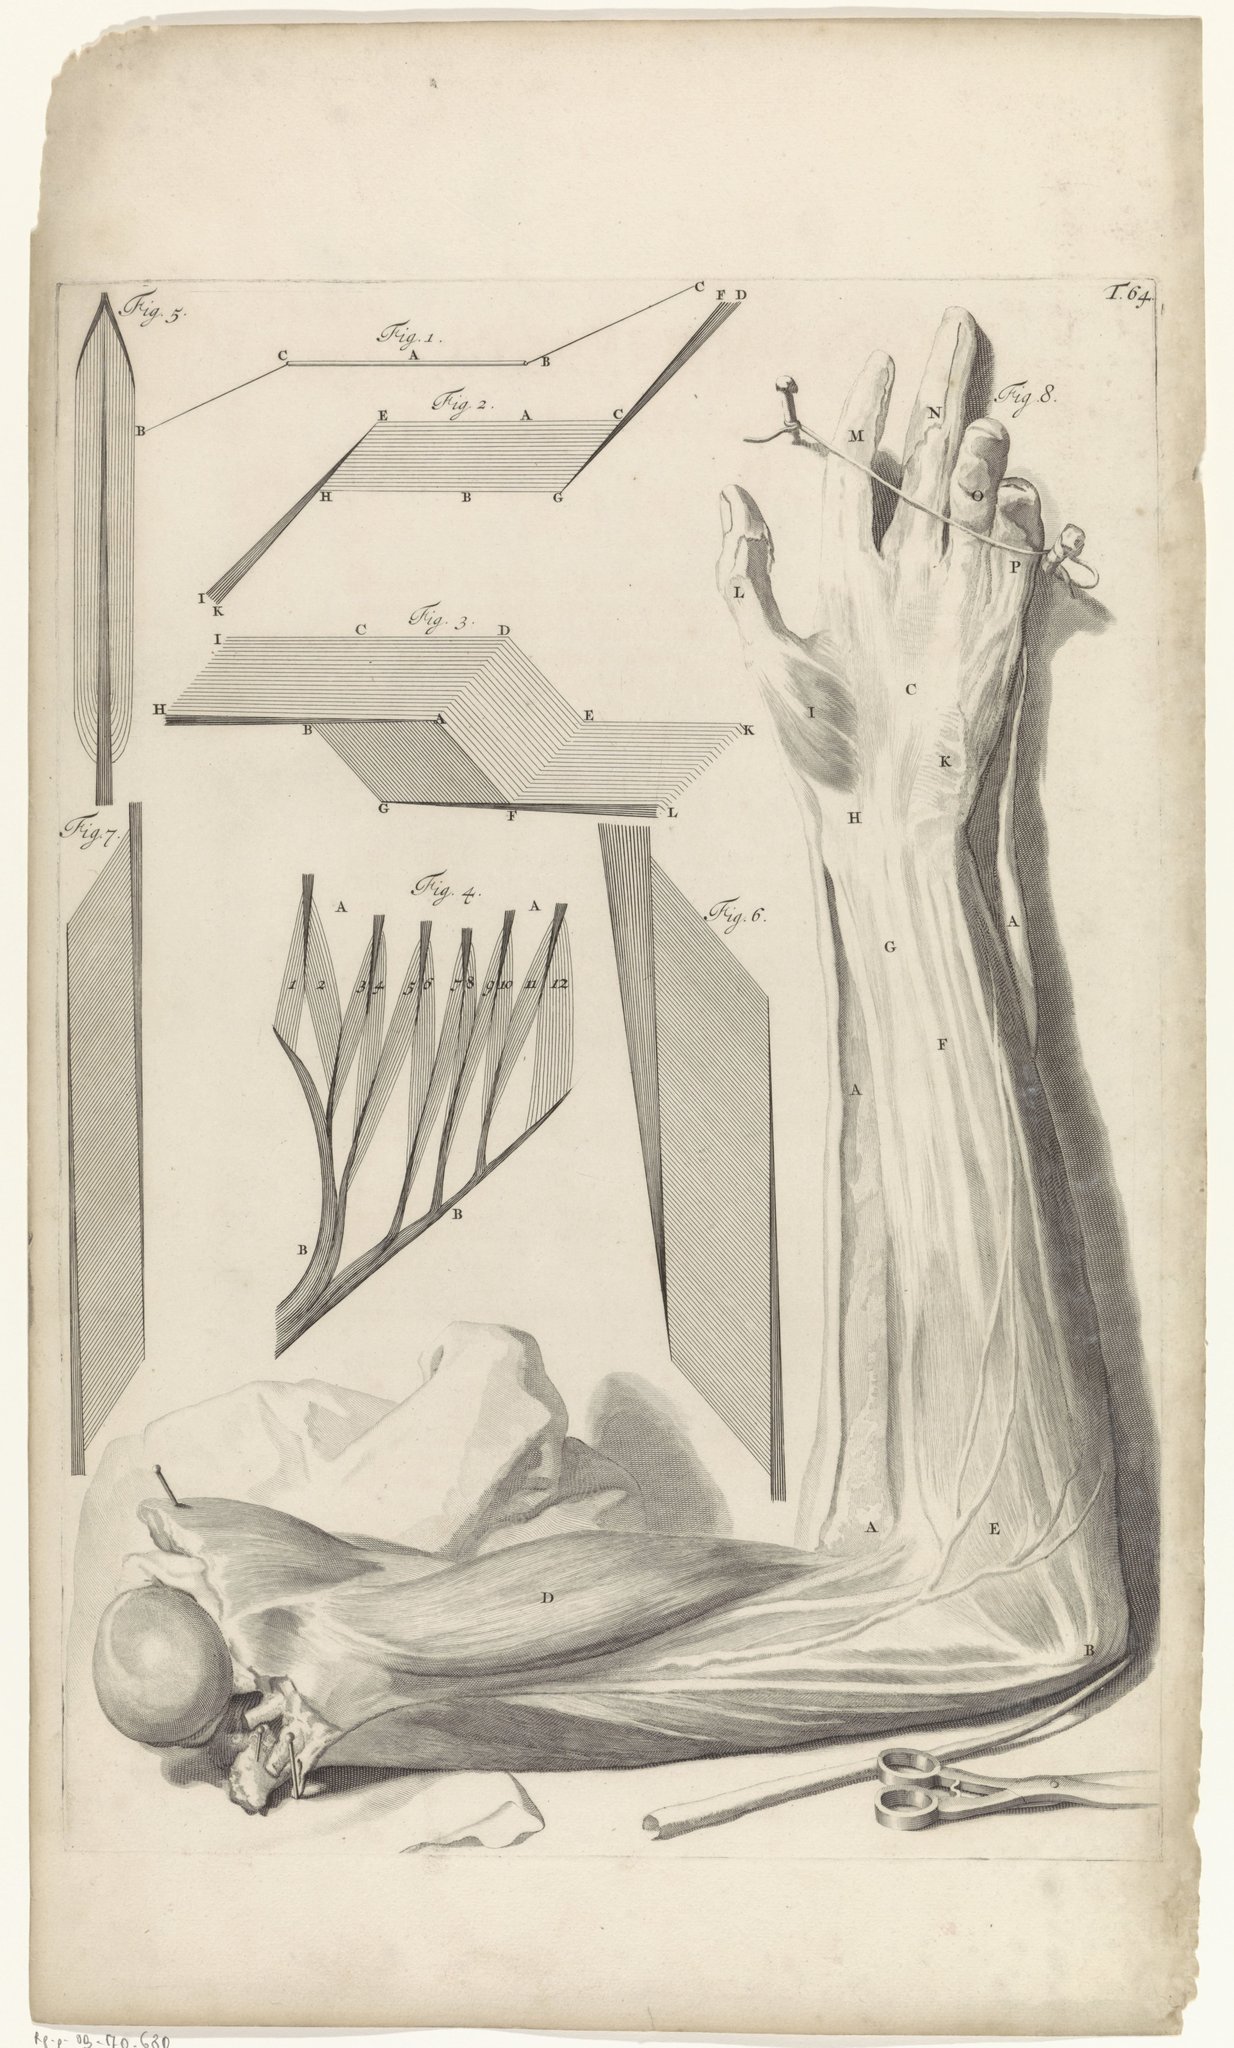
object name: book illustration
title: Anatomische studie van de rechterarm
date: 1685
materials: paper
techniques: engraving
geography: amsterdam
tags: arms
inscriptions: collector's mark: Lugt 2228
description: Boekillustratie voor Bidloo, Godefridus. Anatomia humani corporis centum & quinque tabulis, per art. G. de Lairesse ad vivum delineatis, de monstrata, veterum recentiorumque inventis explicata plurimisque, hactenus non detectis, illustrata. Amsterdam: Weduwe Joannes van Someren, Hendrick Boom en erven Dirk Boom, 1685.